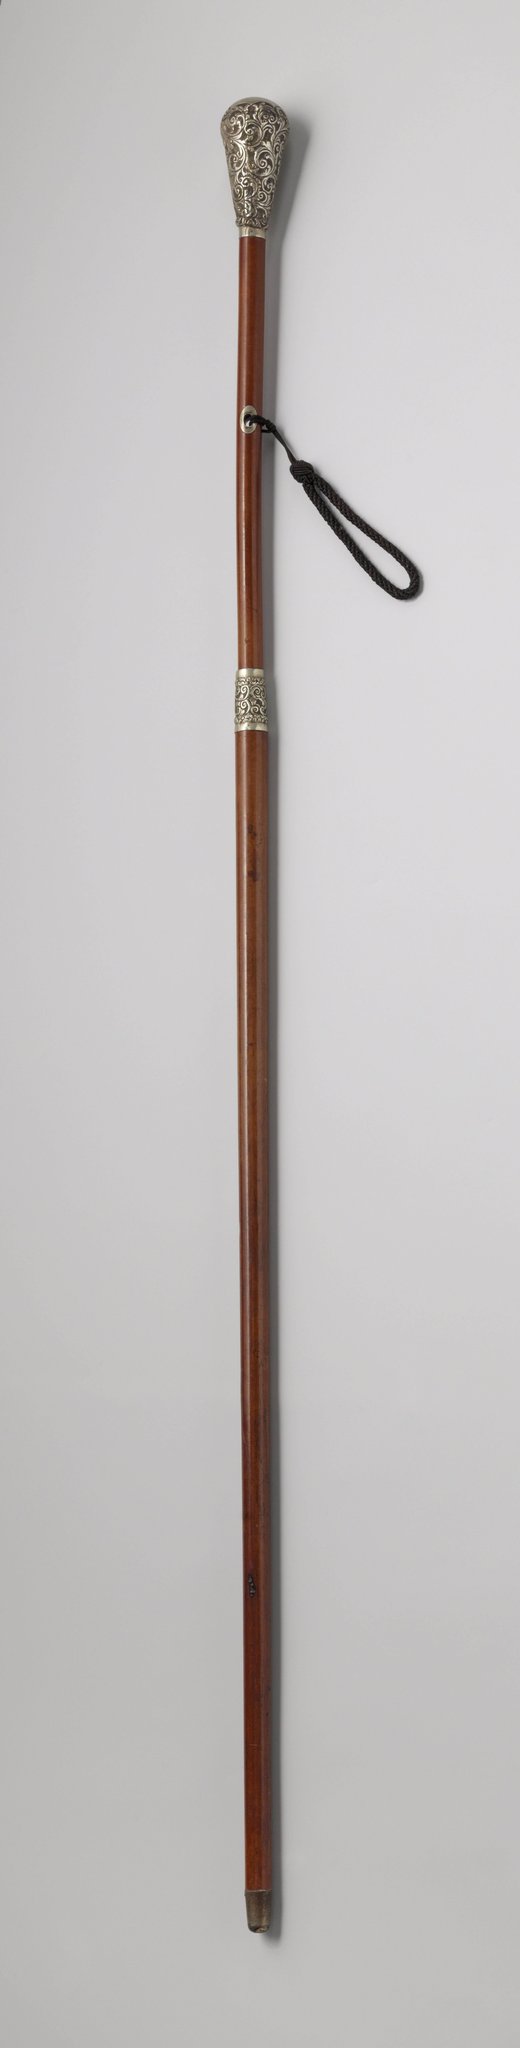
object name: walking stick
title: Wandelstaf met zilveren knop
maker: Anonymous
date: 1700-1800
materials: rattan, silver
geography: indonesia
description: Wandelstaf of wandelstok vervaardigd uit rotting maar naar Europees model. Zilveren handvat.